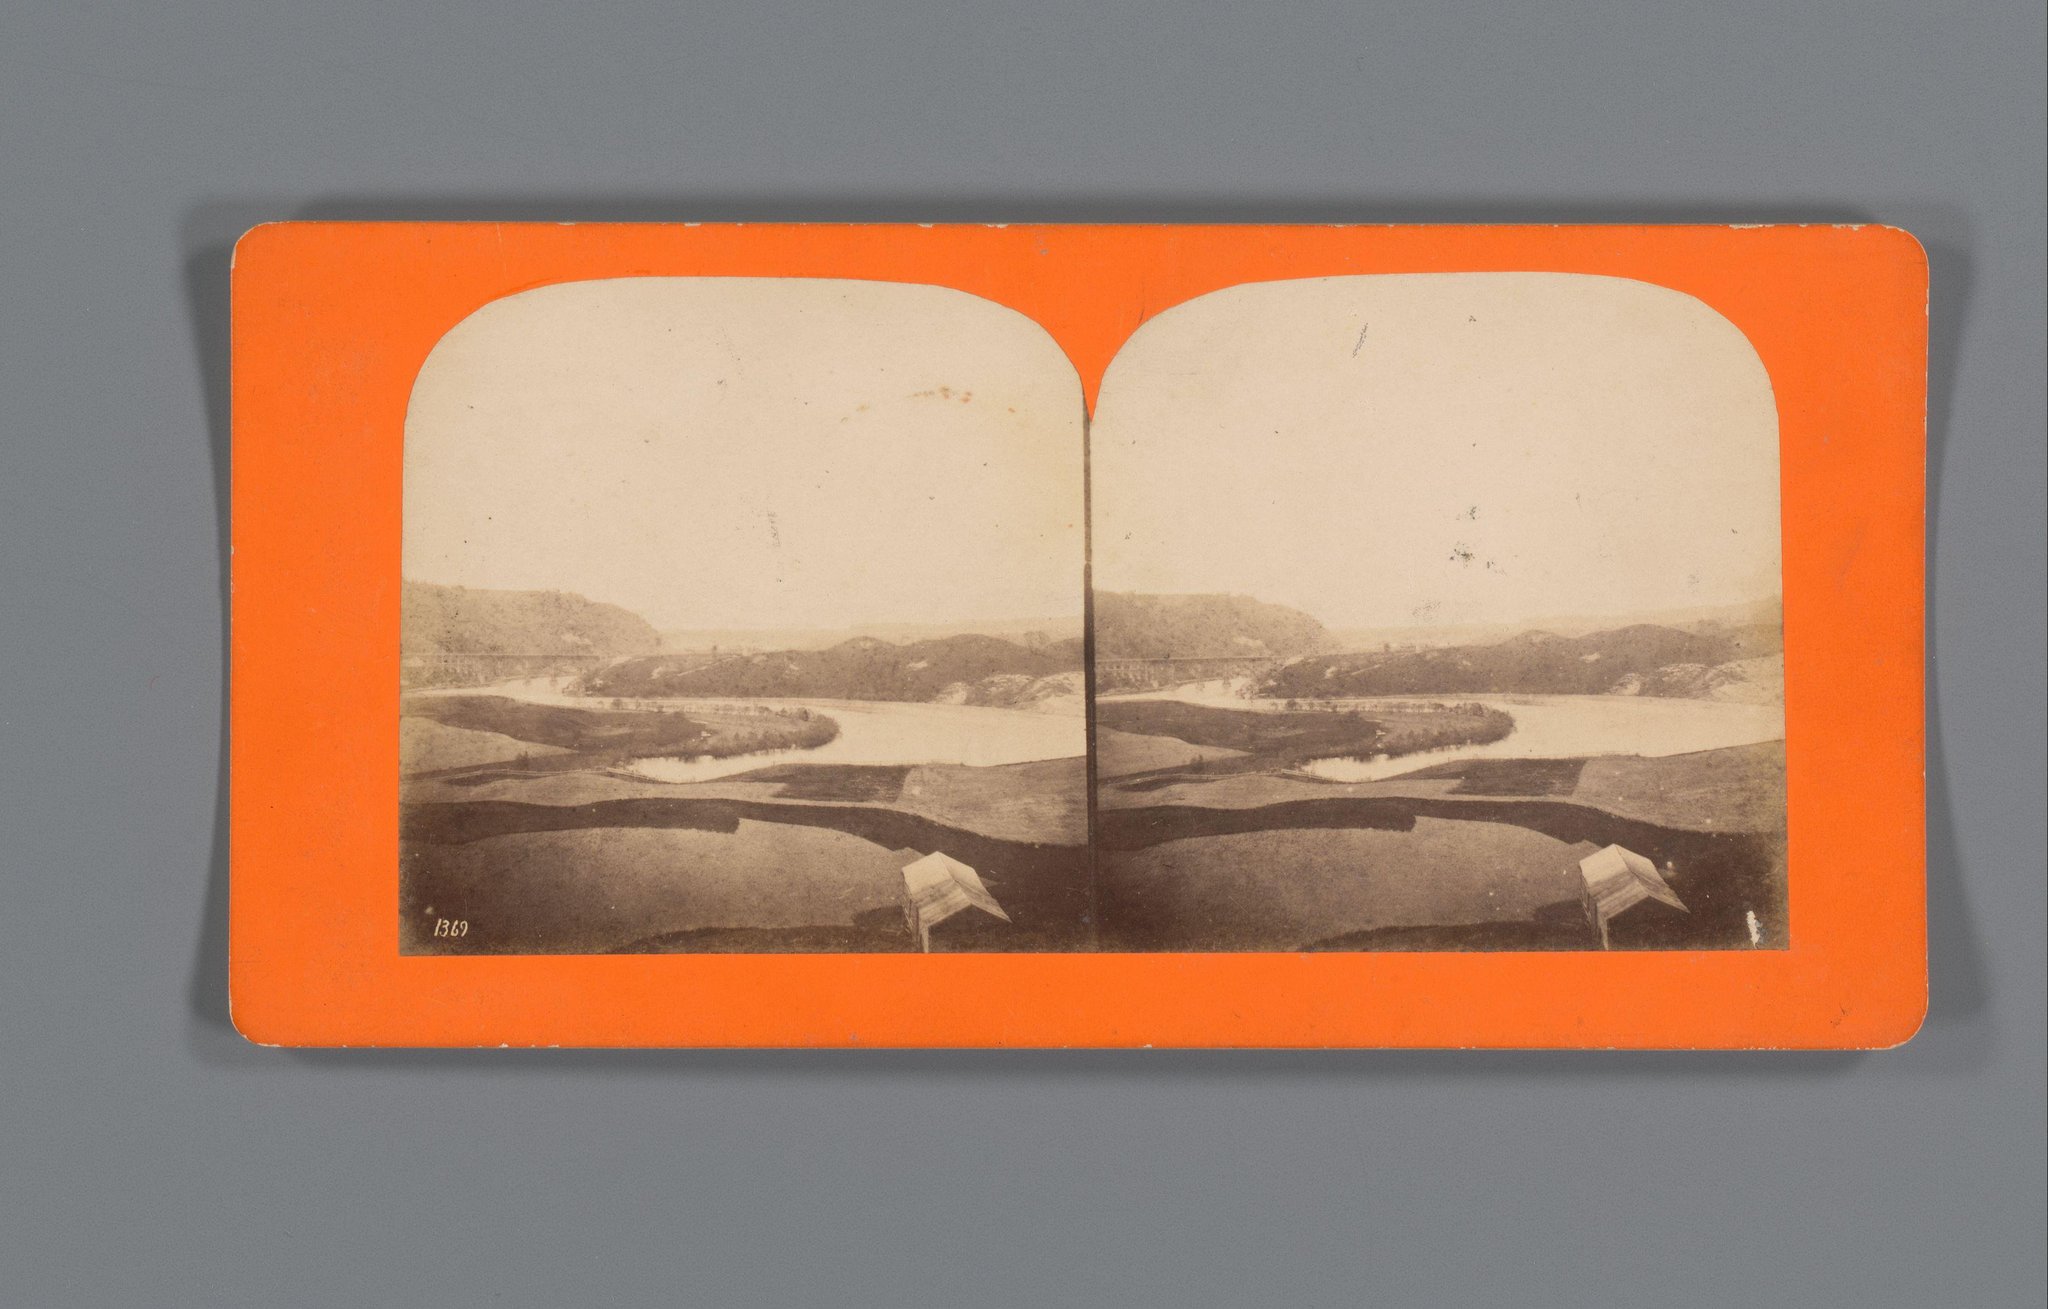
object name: stereograph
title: Gezicht op Trondheim, Noorwegen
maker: knud knudsen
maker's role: fotograaf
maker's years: 1832-1915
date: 1873-1890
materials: cardboard, paper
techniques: albumen print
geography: trondheim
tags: landscapes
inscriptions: number: ‘1369’